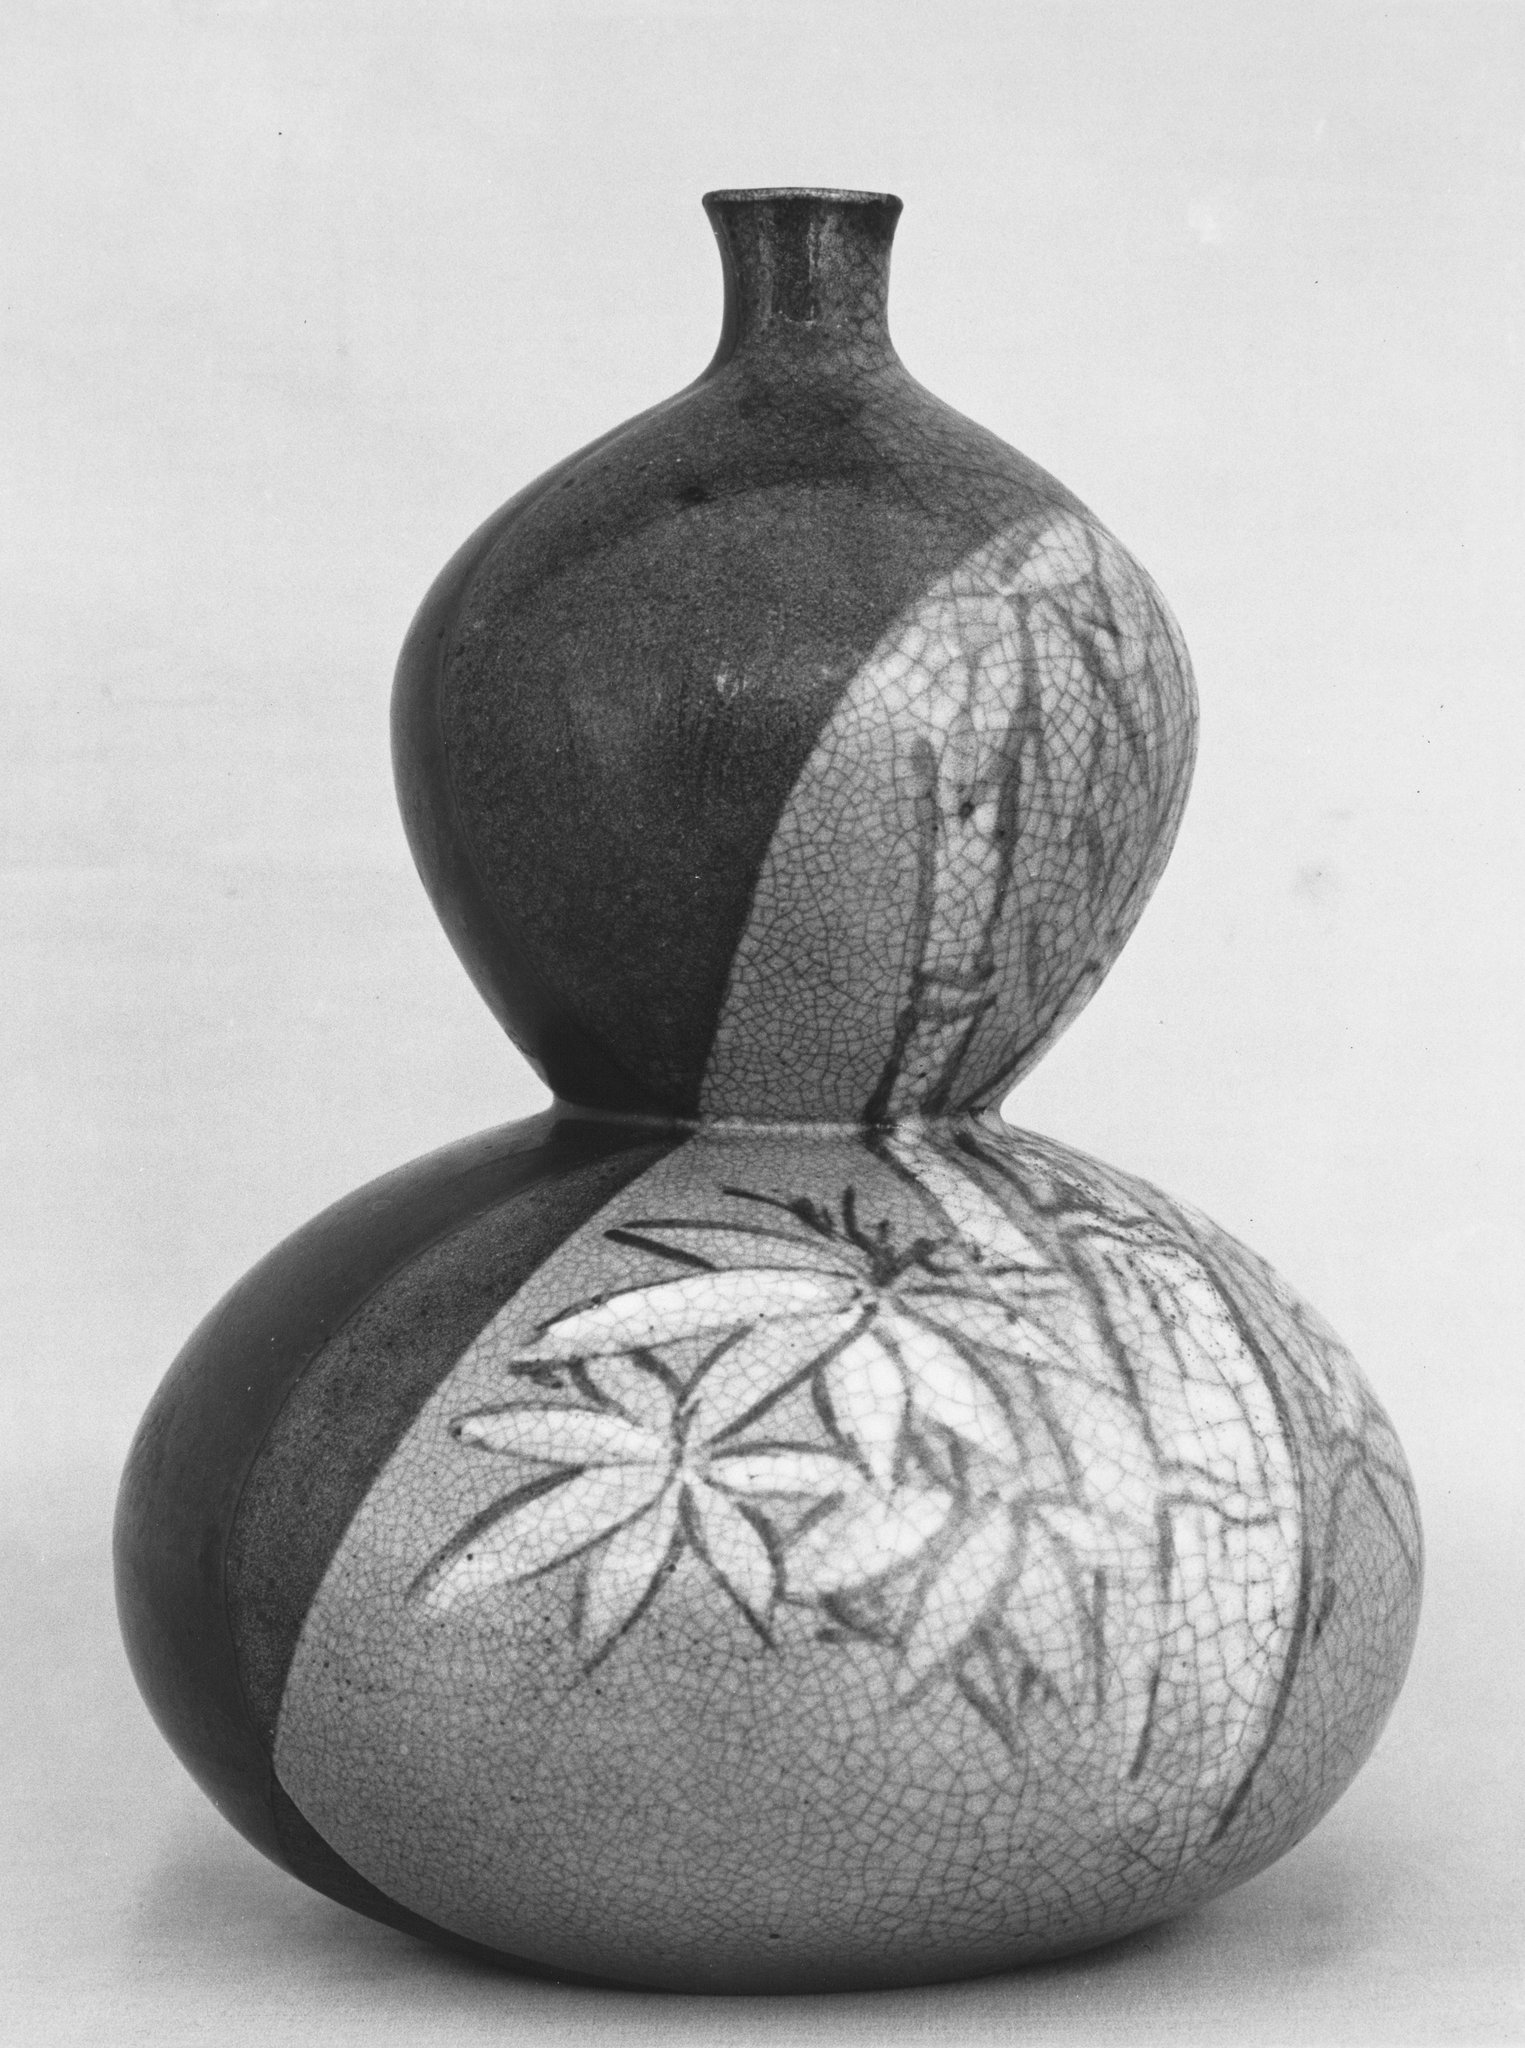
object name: bottle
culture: japanese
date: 1801-1900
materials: clay, glaze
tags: bamboo,leaves